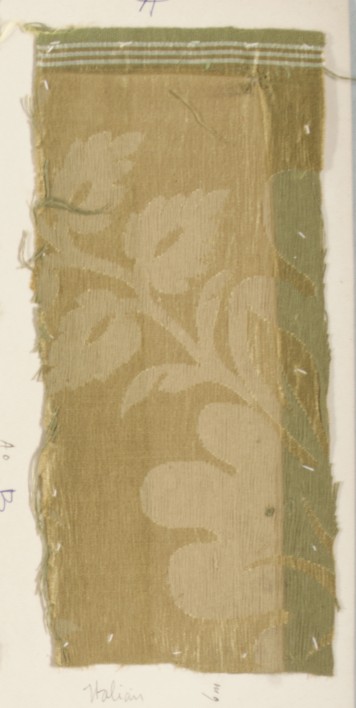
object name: fragment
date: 1601-1700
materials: silk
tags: leaves